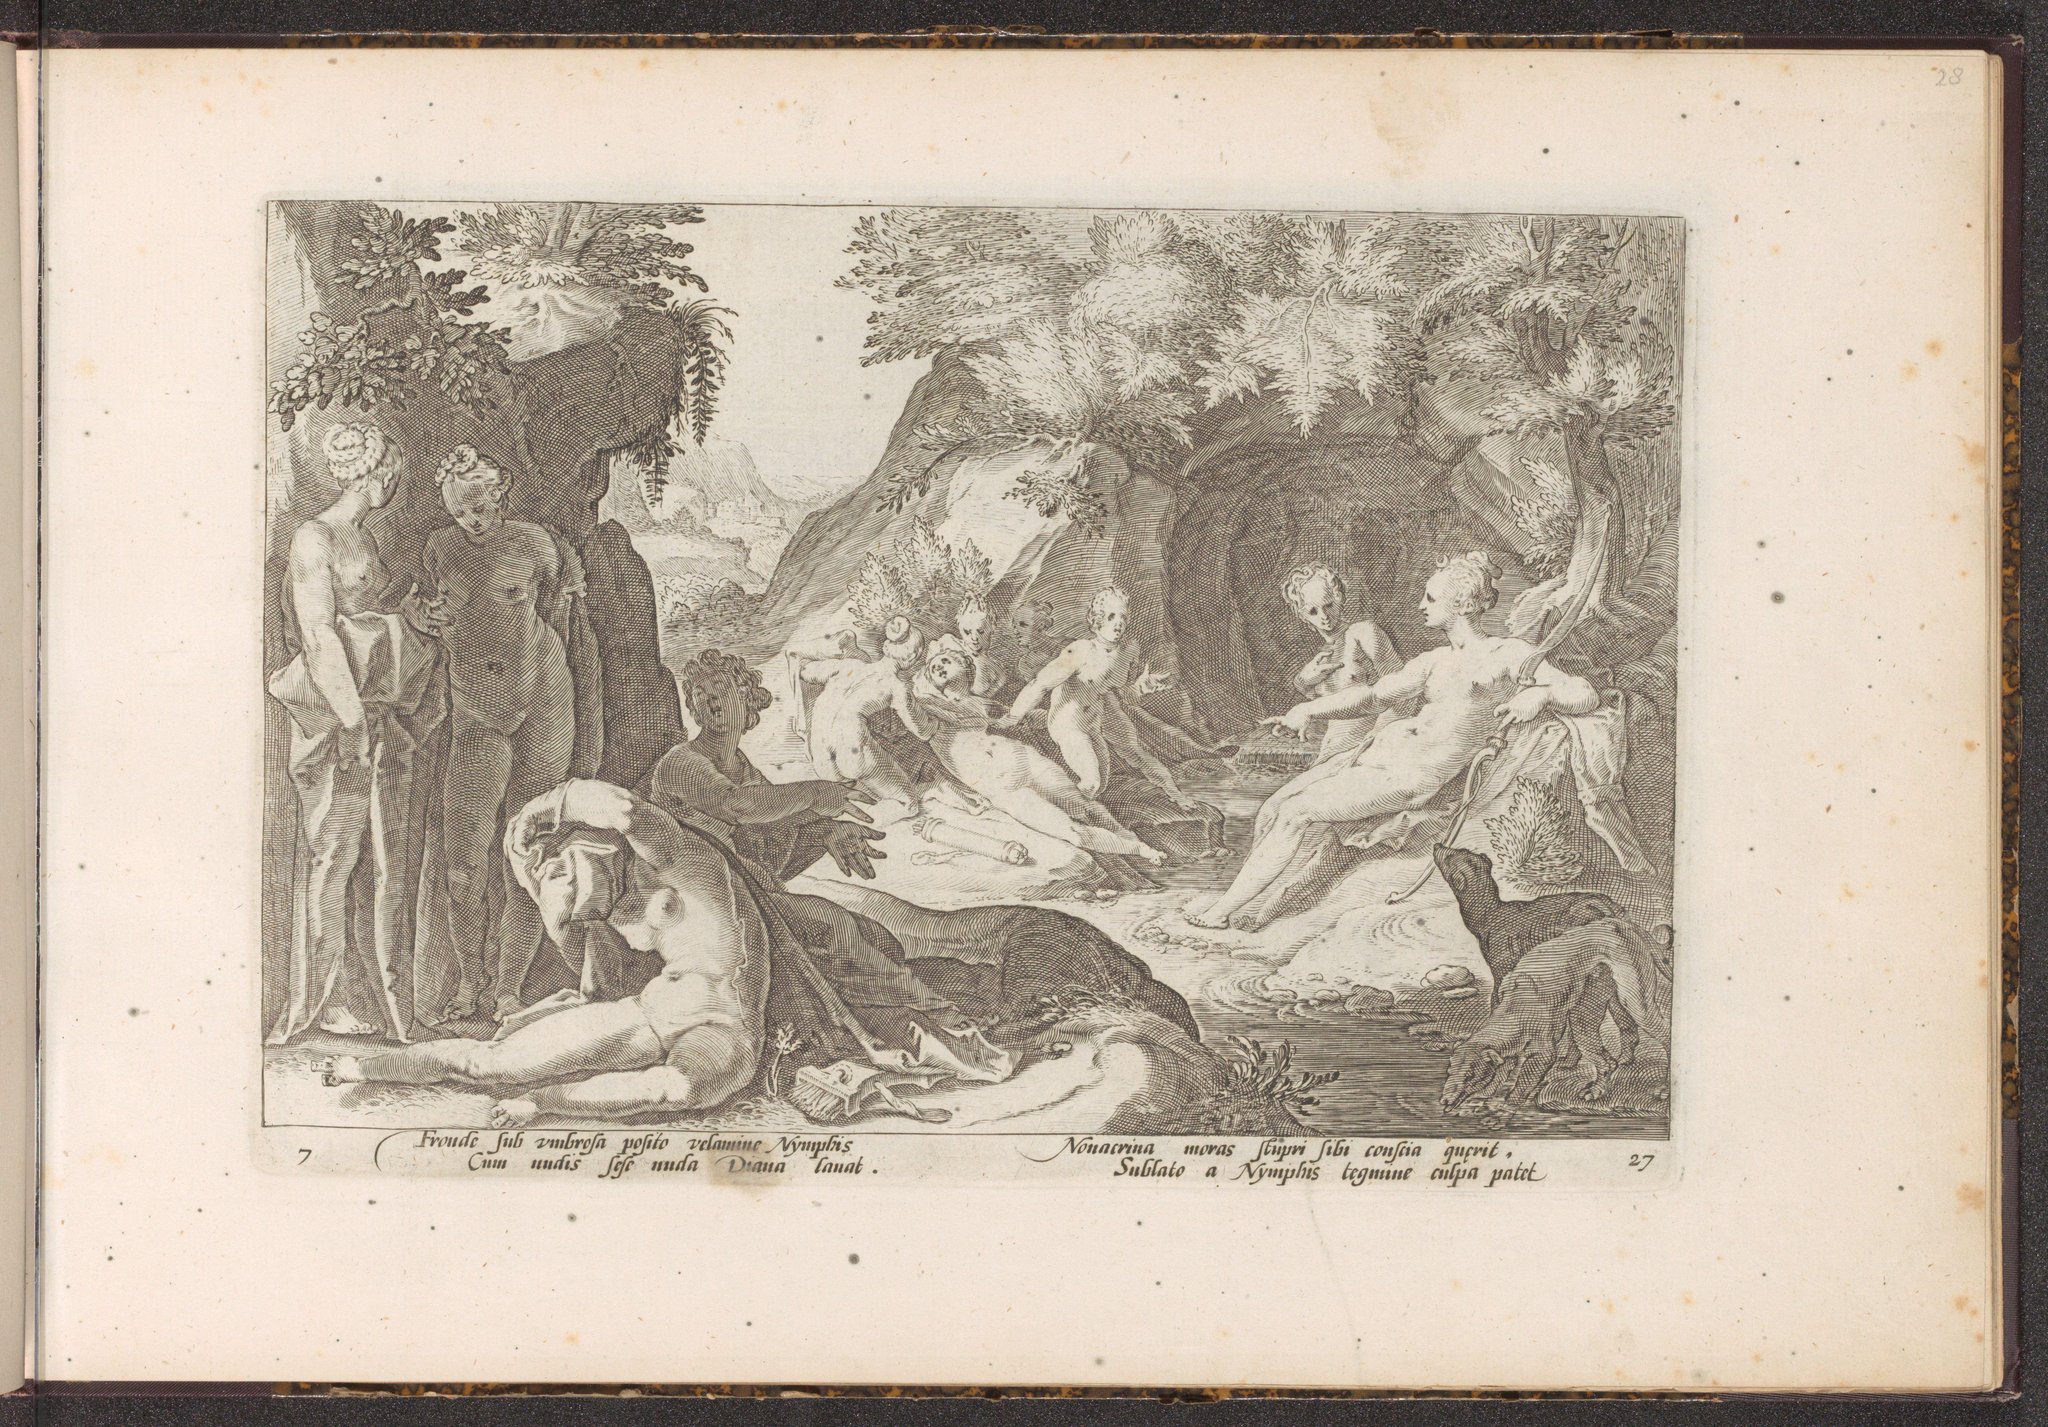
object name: album leaf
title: Diana ontdekt de zwangerschap van Callisto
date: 1590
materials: paper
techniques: engraving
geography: haarlem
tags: diana with her nymphs discovers the pregnancy of callisto, pregnancy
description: Als Diana en haar nimfen besluiten bij een grot een bad te nemen, ontdekt ze dat Callisto zwanger is. Callisto wordt door anderen gedwongen zich uit te kleden en Diana steekt een beschuldigende vinger naar haar uit. Onder de voorstelling twee keer twee versregels in het Latijn. De prent maakt deel uit van een album.